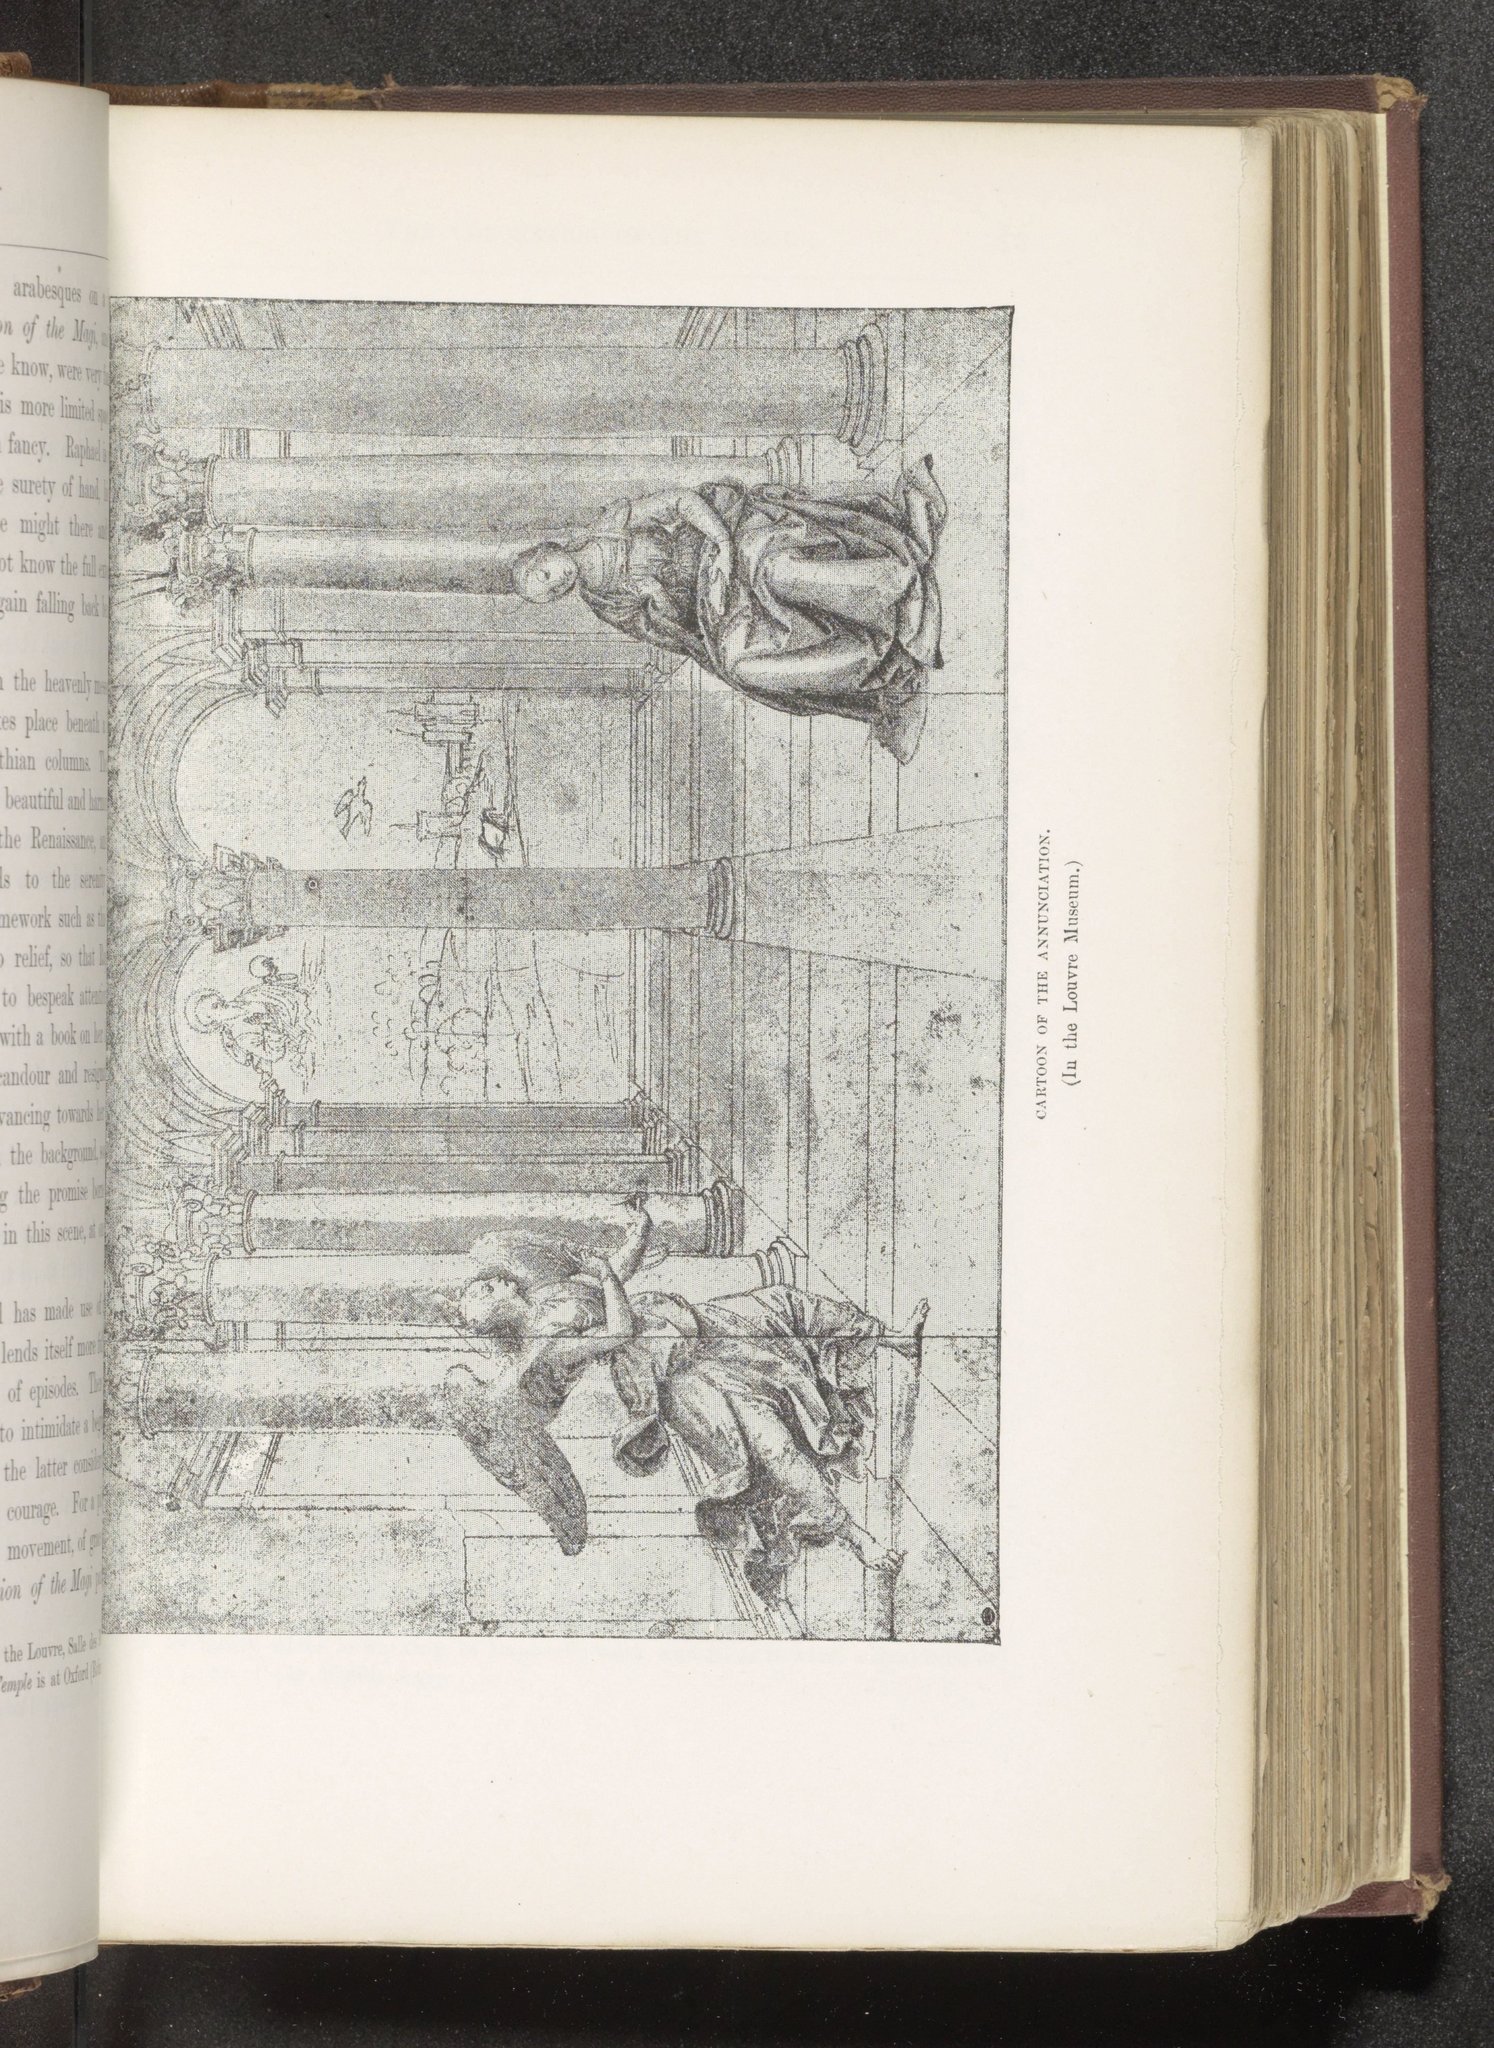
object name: page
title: Fotoreproductie van een tekening, voorstellende de Annunciatie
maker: Anonymous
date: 1872-1882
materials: paper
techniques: autotype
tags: the annunciation: mary sitting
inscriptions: inscription: ‘(In the Louvre Museum.)’